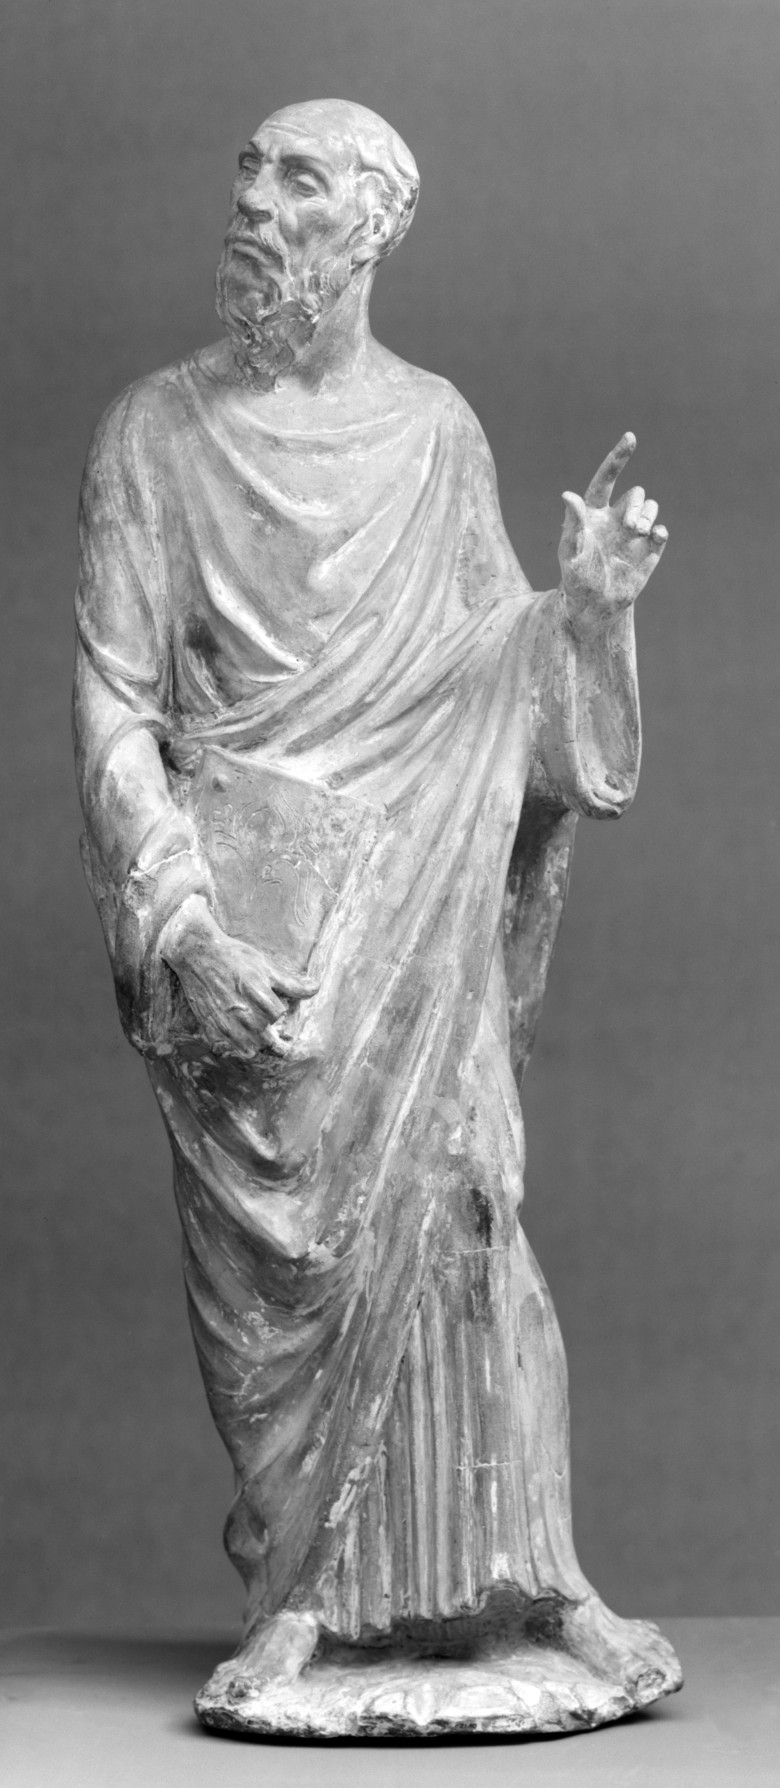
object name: statue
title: Renaissance-style statue of a male saint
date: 1801-1900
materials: terracotta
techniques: polychromy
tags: men,saints